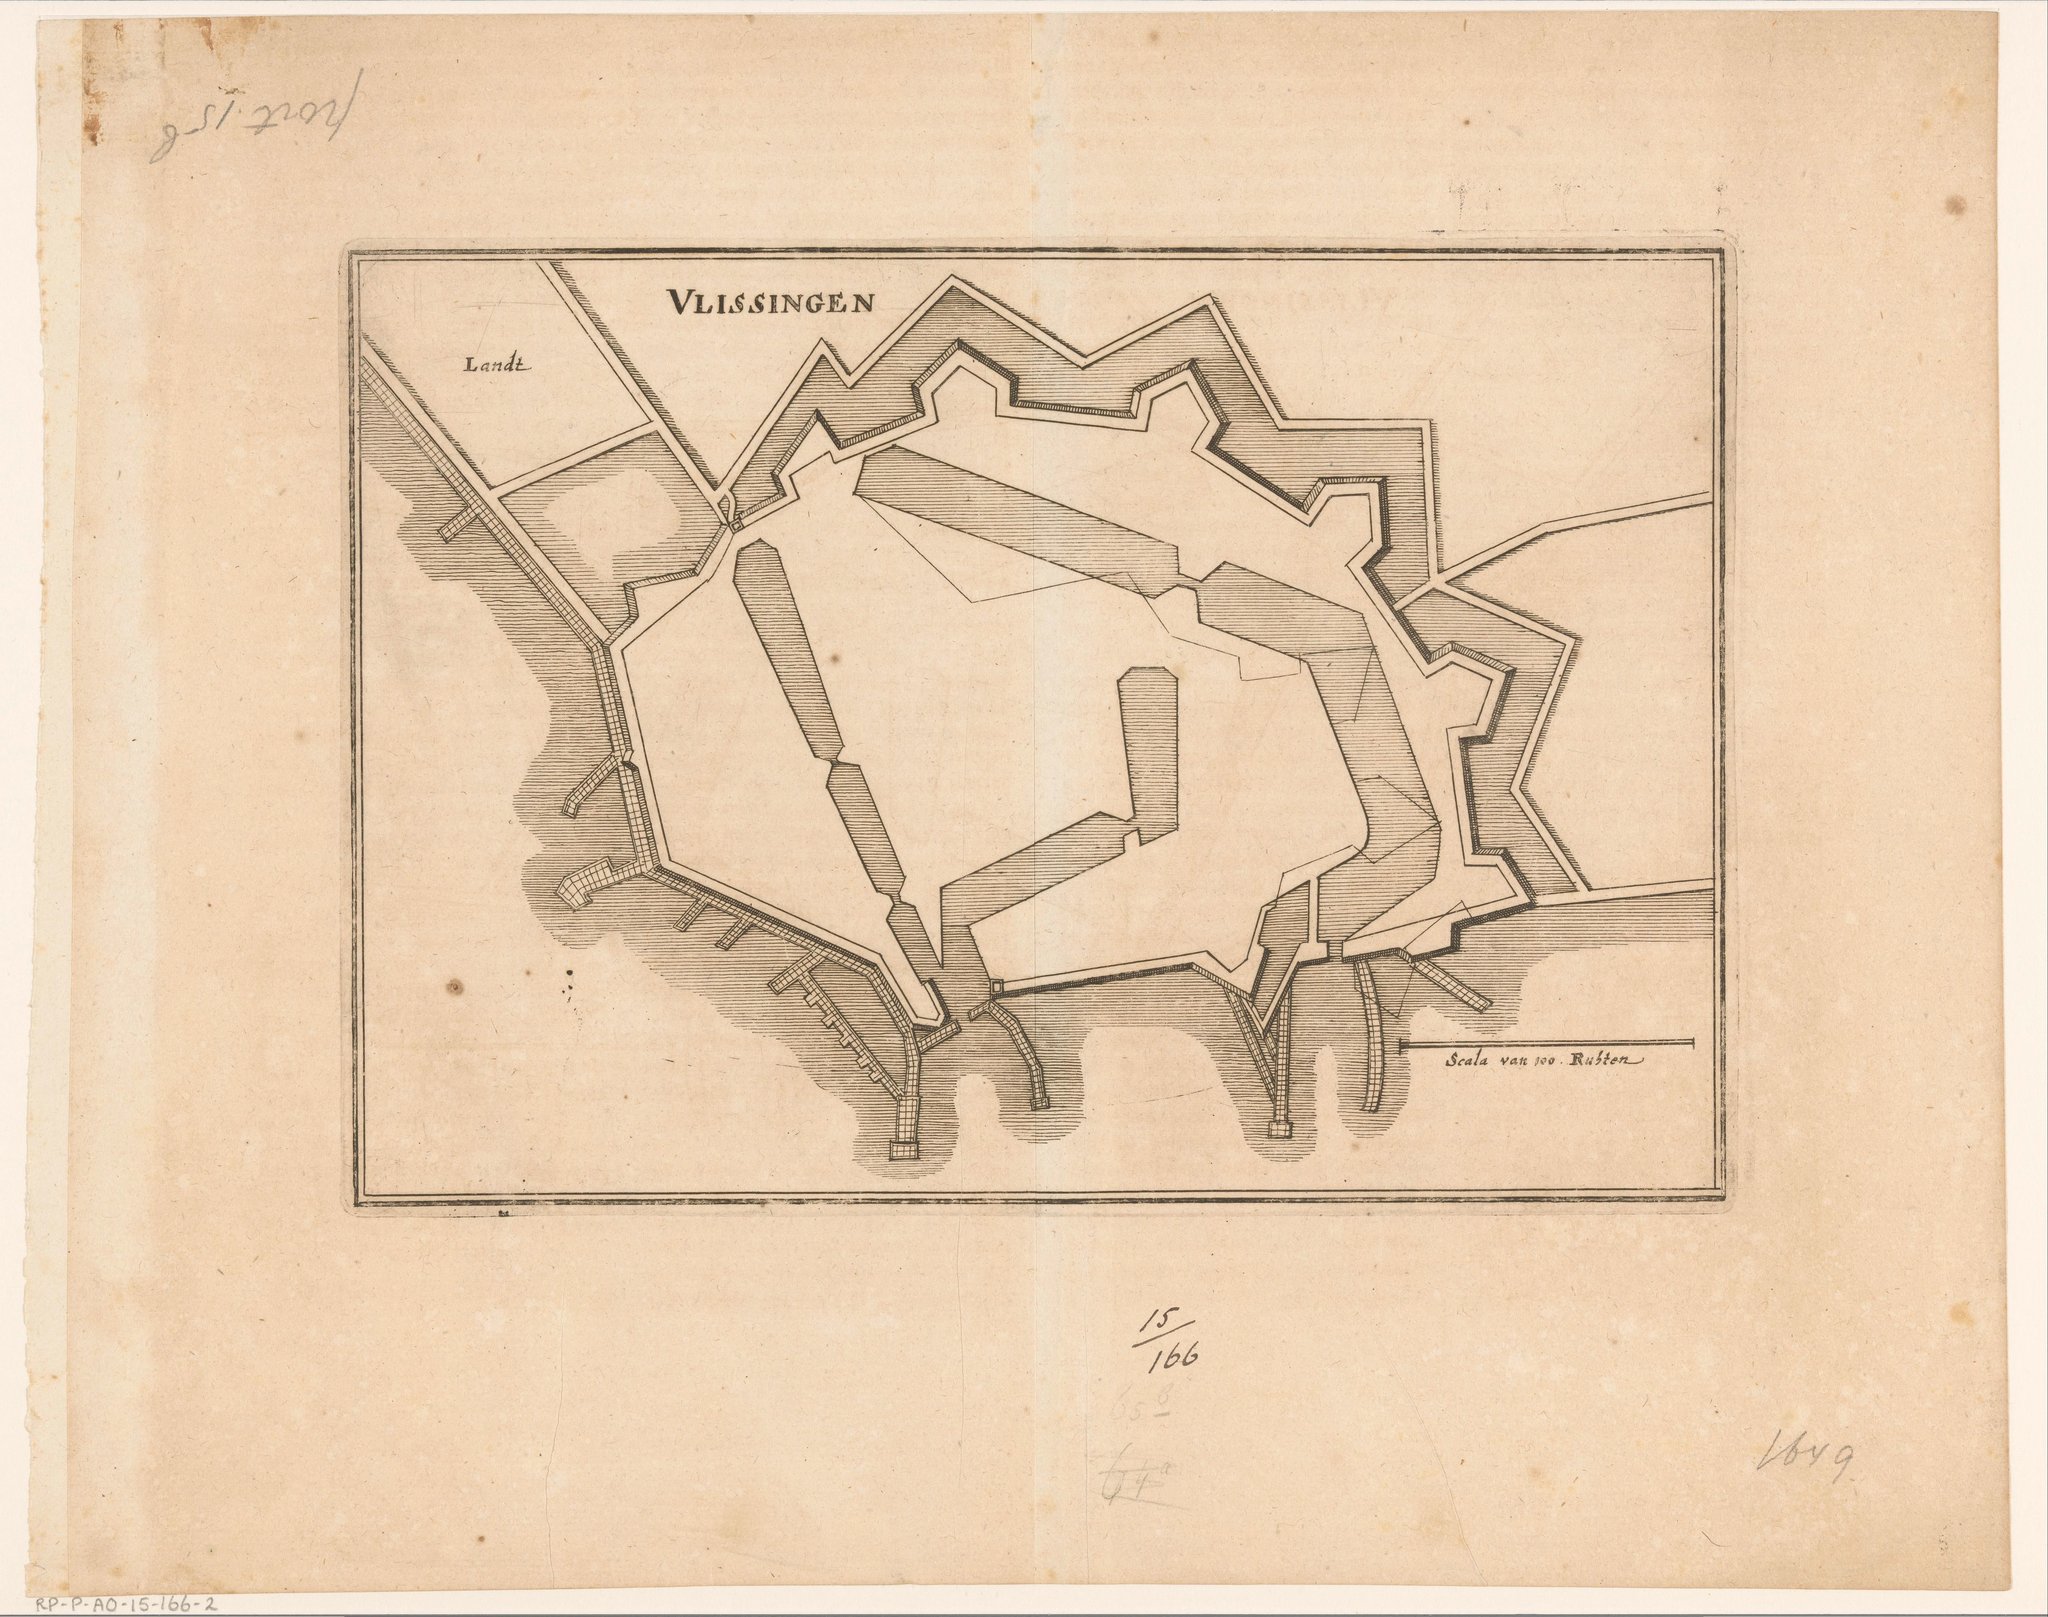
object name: print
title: Vestingplattegrond van Vlissingen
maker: caspar merian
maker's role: print maker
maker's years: 1627-1689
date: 1654-1700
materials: paper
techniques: etching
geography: frankfurt am main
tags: fortified city, maps of cities, flushing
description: Prent gebruikt in: Zeiller, Martin. M.Z. Topographia Circuli Burgundici Oder Beschreibung une Eigentliche Abbildung der Vornehmsten Örter in dem Hochlöblichen Burgund- un Niderlandischen Crayse. Frankfurt am Main: Caspar Merian, 1654. Of in: Zeiller, Martin. M. Z. Topographia Germaniae-Inferioris vel Circuli-Burgundici, das ist Beschreibung (…). Frankfurt am Main: Caspar Merian, 1659. Of in een van de twee latere uitgaven van deze publicatie die, hoewel het jaar 1659 erin staat vermeld als jaar van uitgave, zijn uitgegeven in respectievelijk ca. 1670 en ca. 1700.